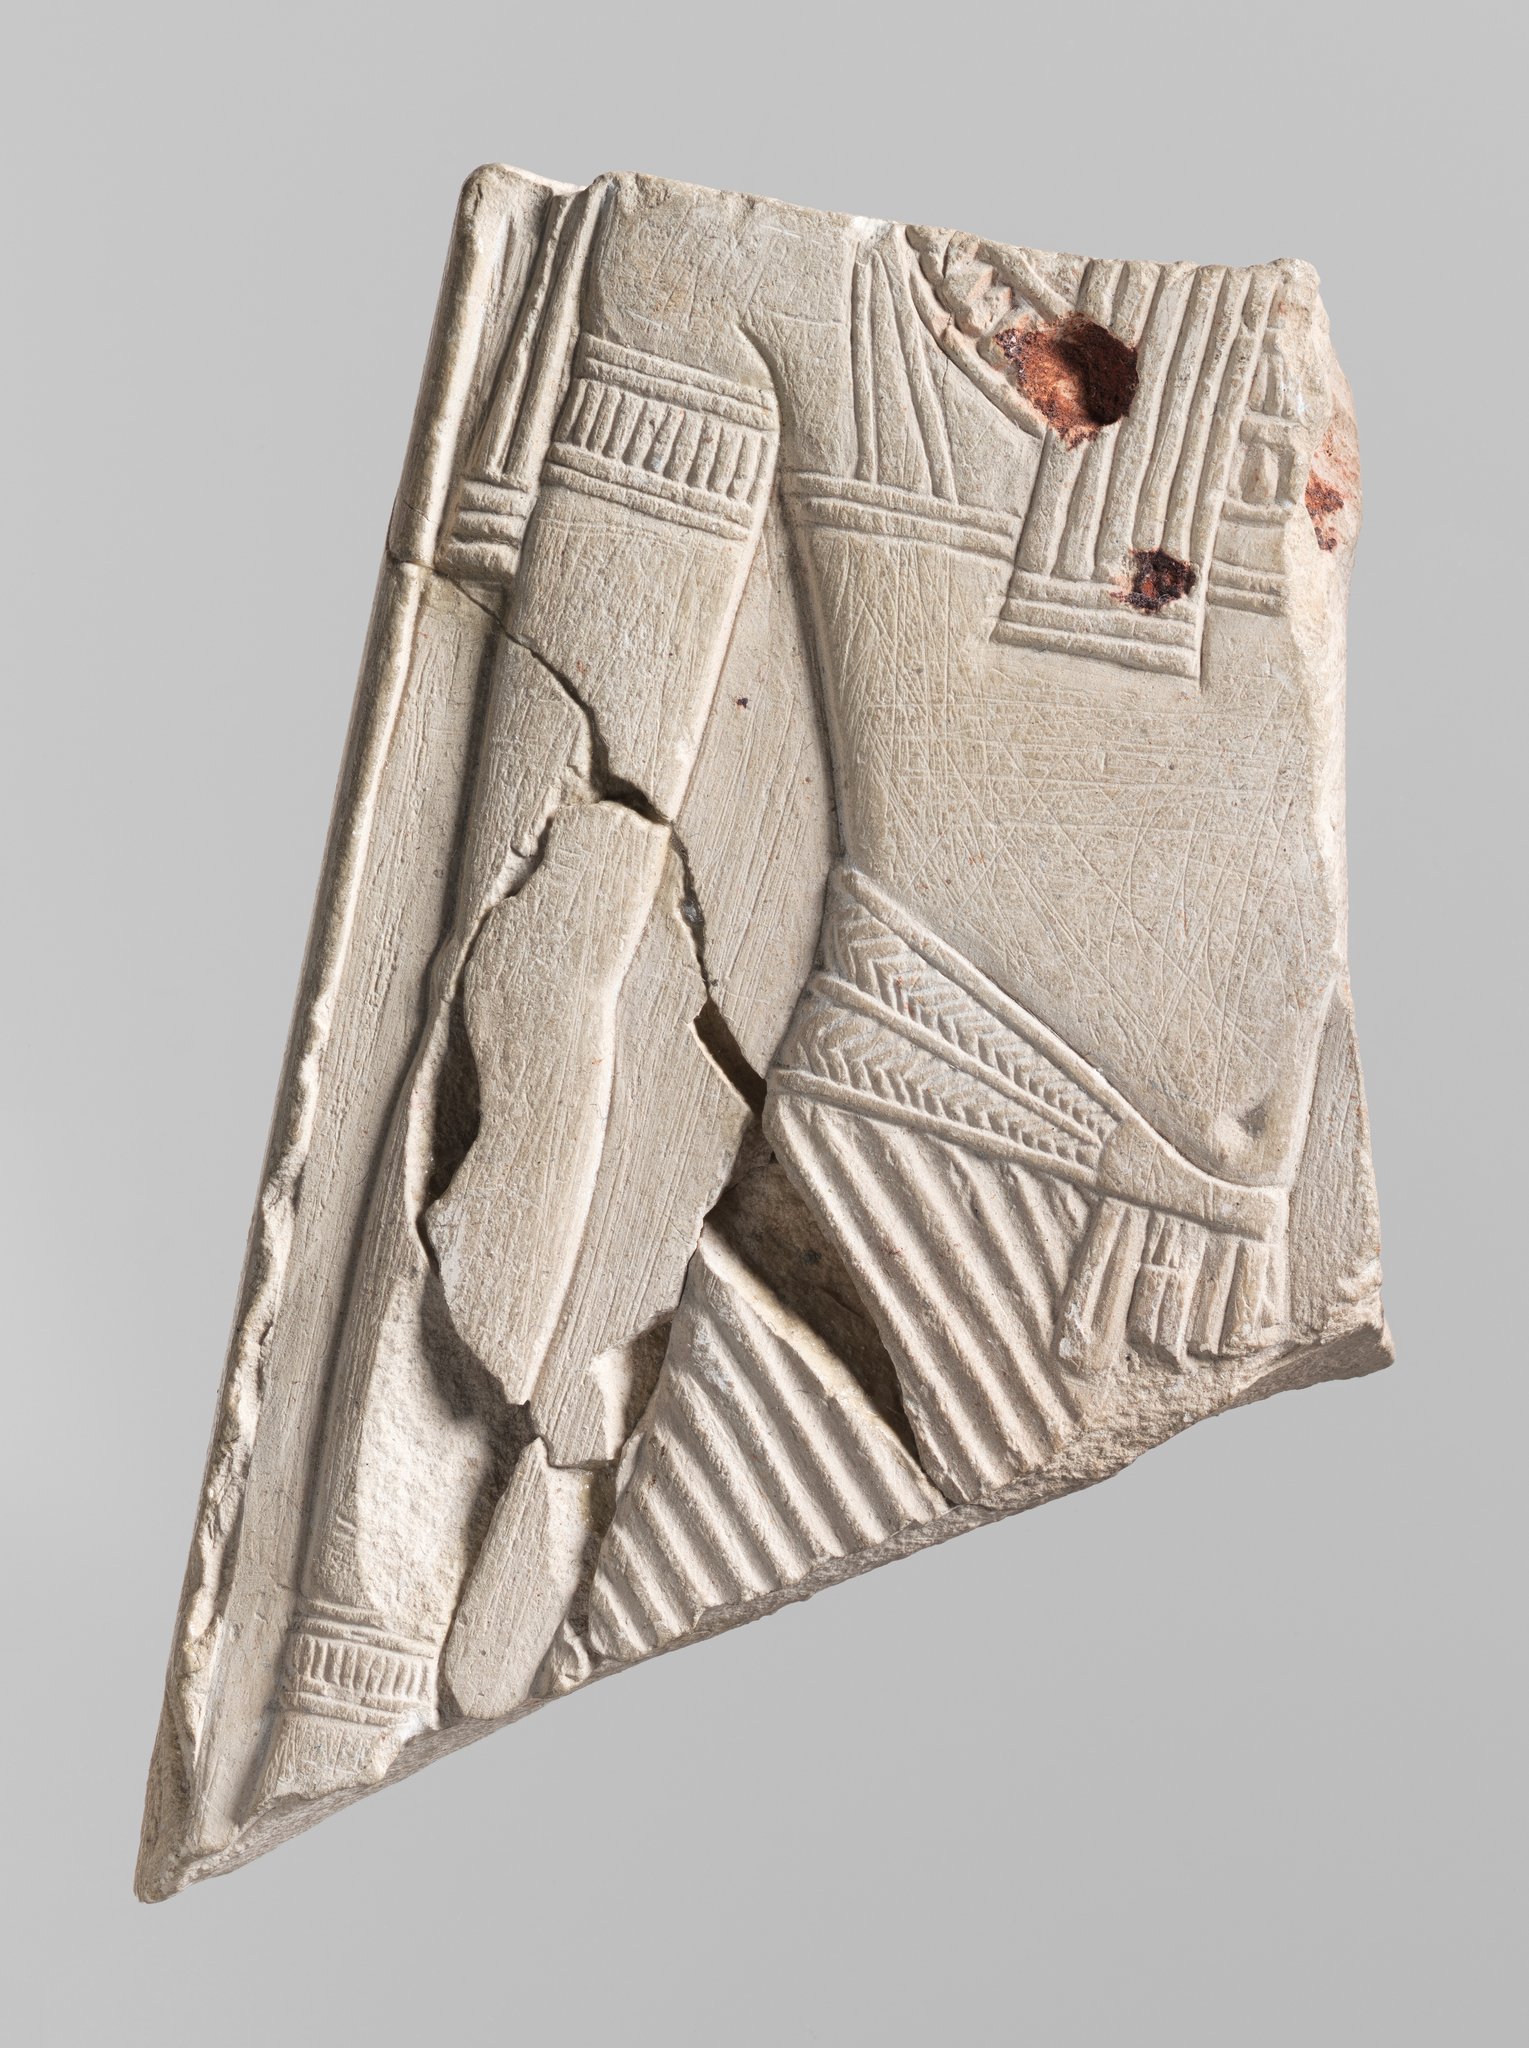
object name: relief, two sided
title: Two-sided relief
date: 664-343 BCE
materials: limestone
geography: egypt